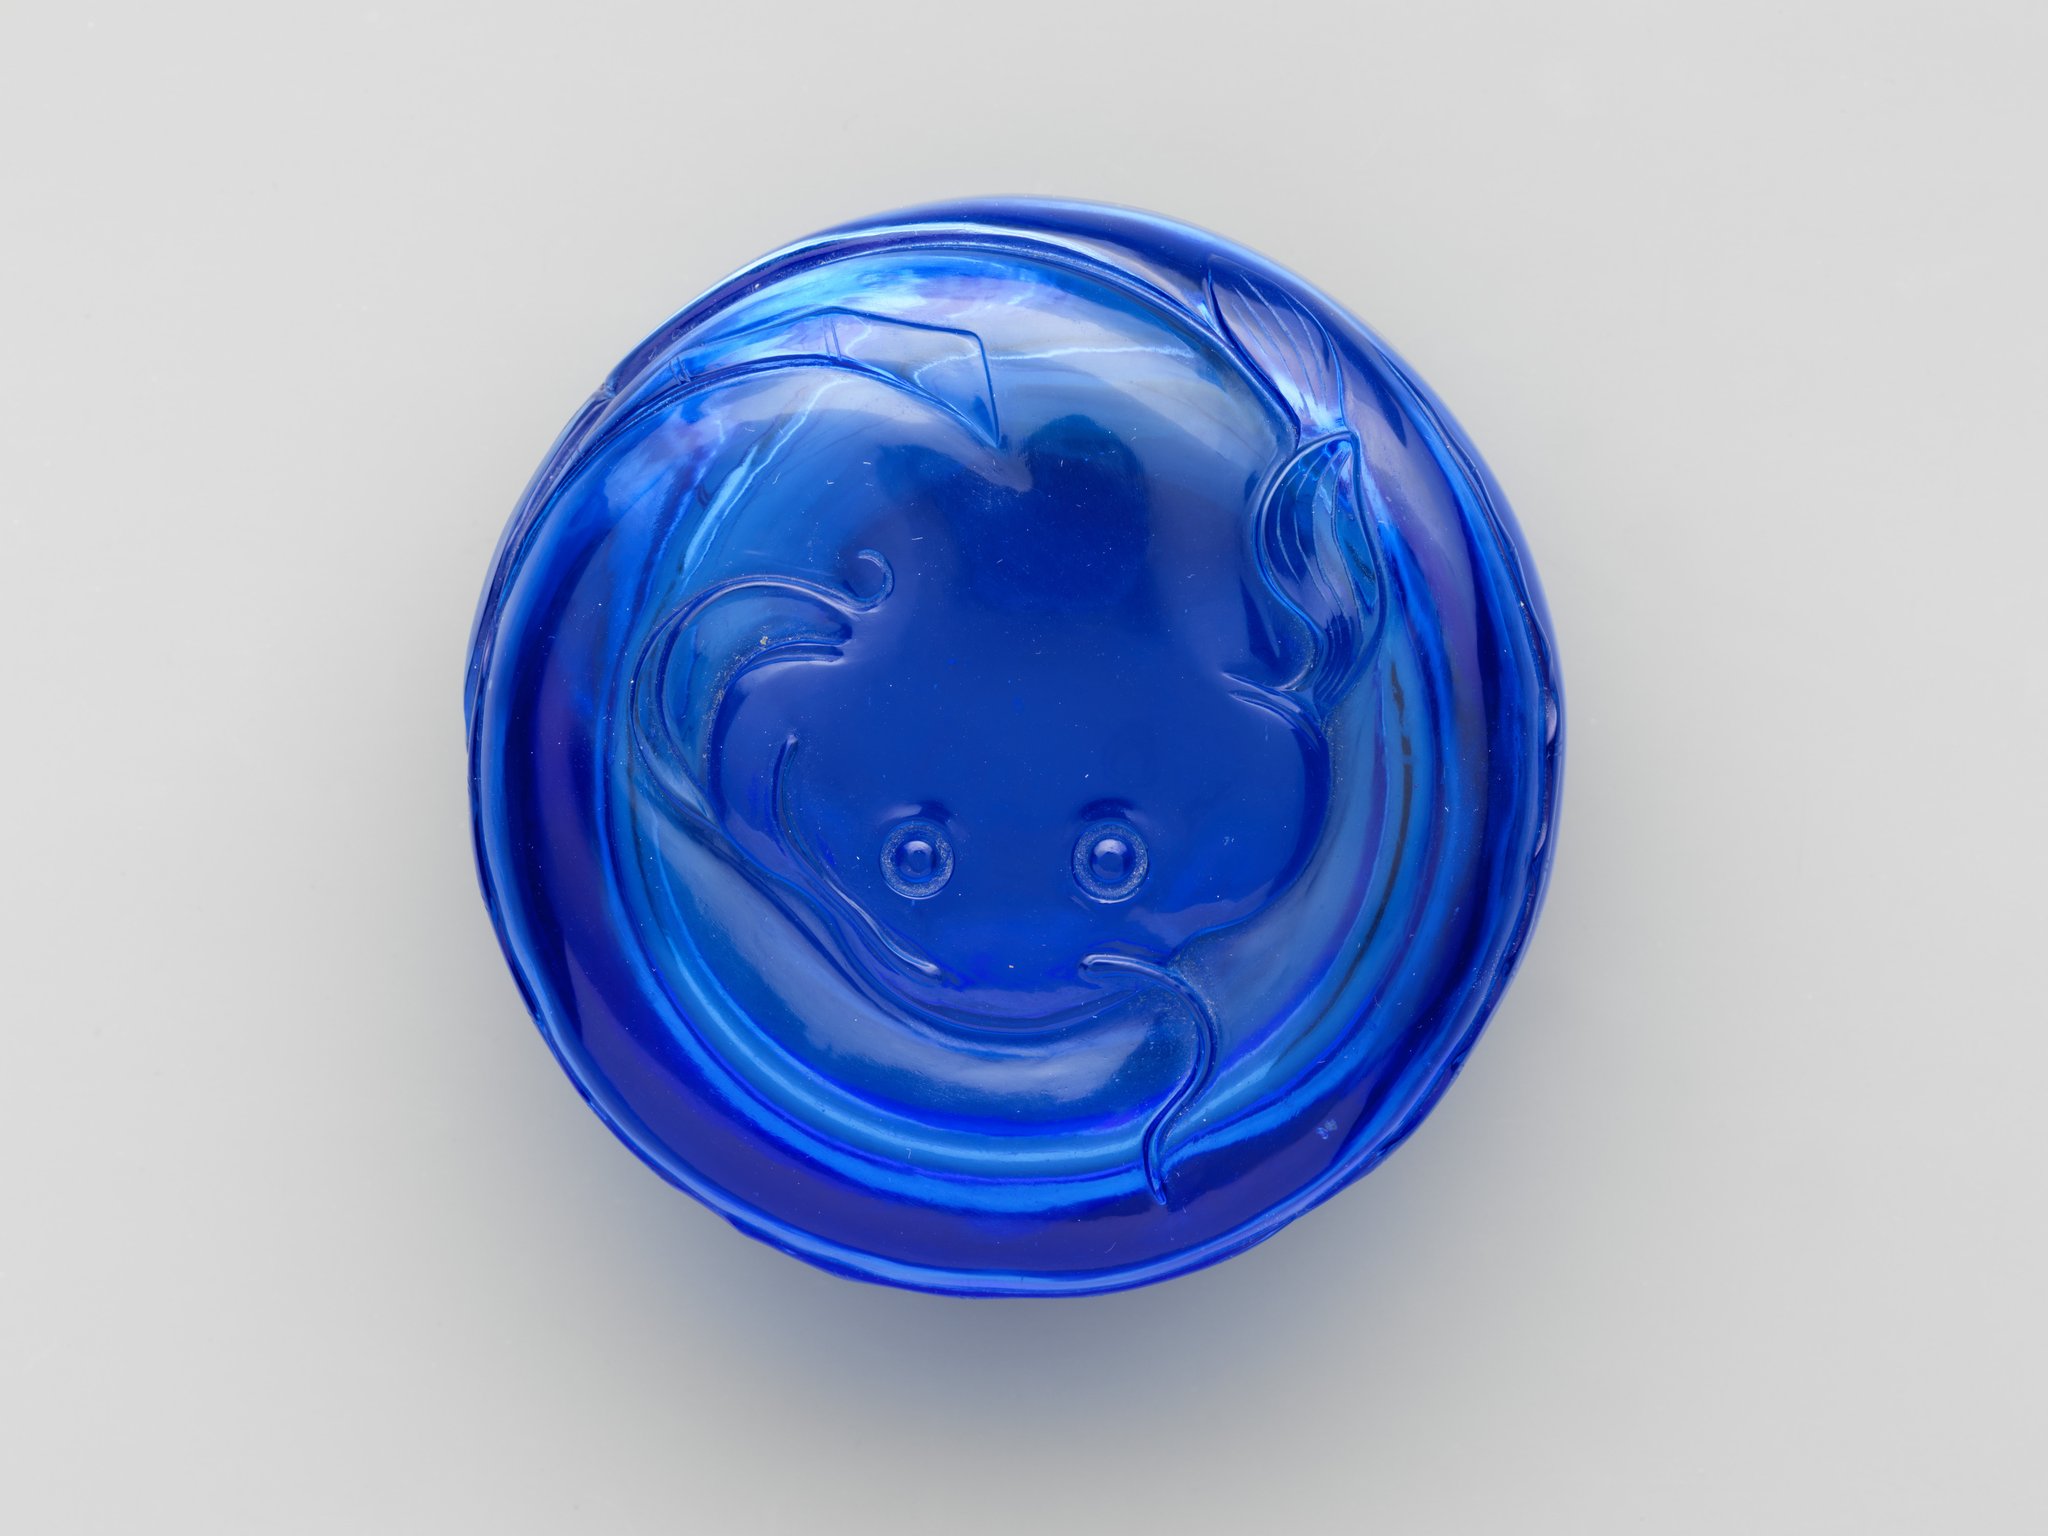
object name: covered box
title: Covered box with catfish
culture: chinese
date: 1701-1800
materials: glass